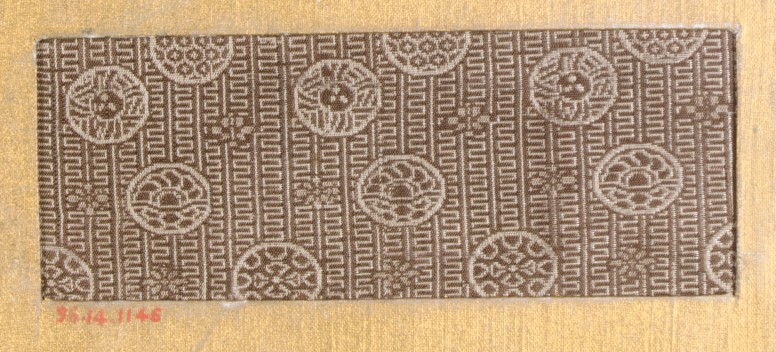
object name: piece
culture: japanese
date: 1701-1900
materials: silk